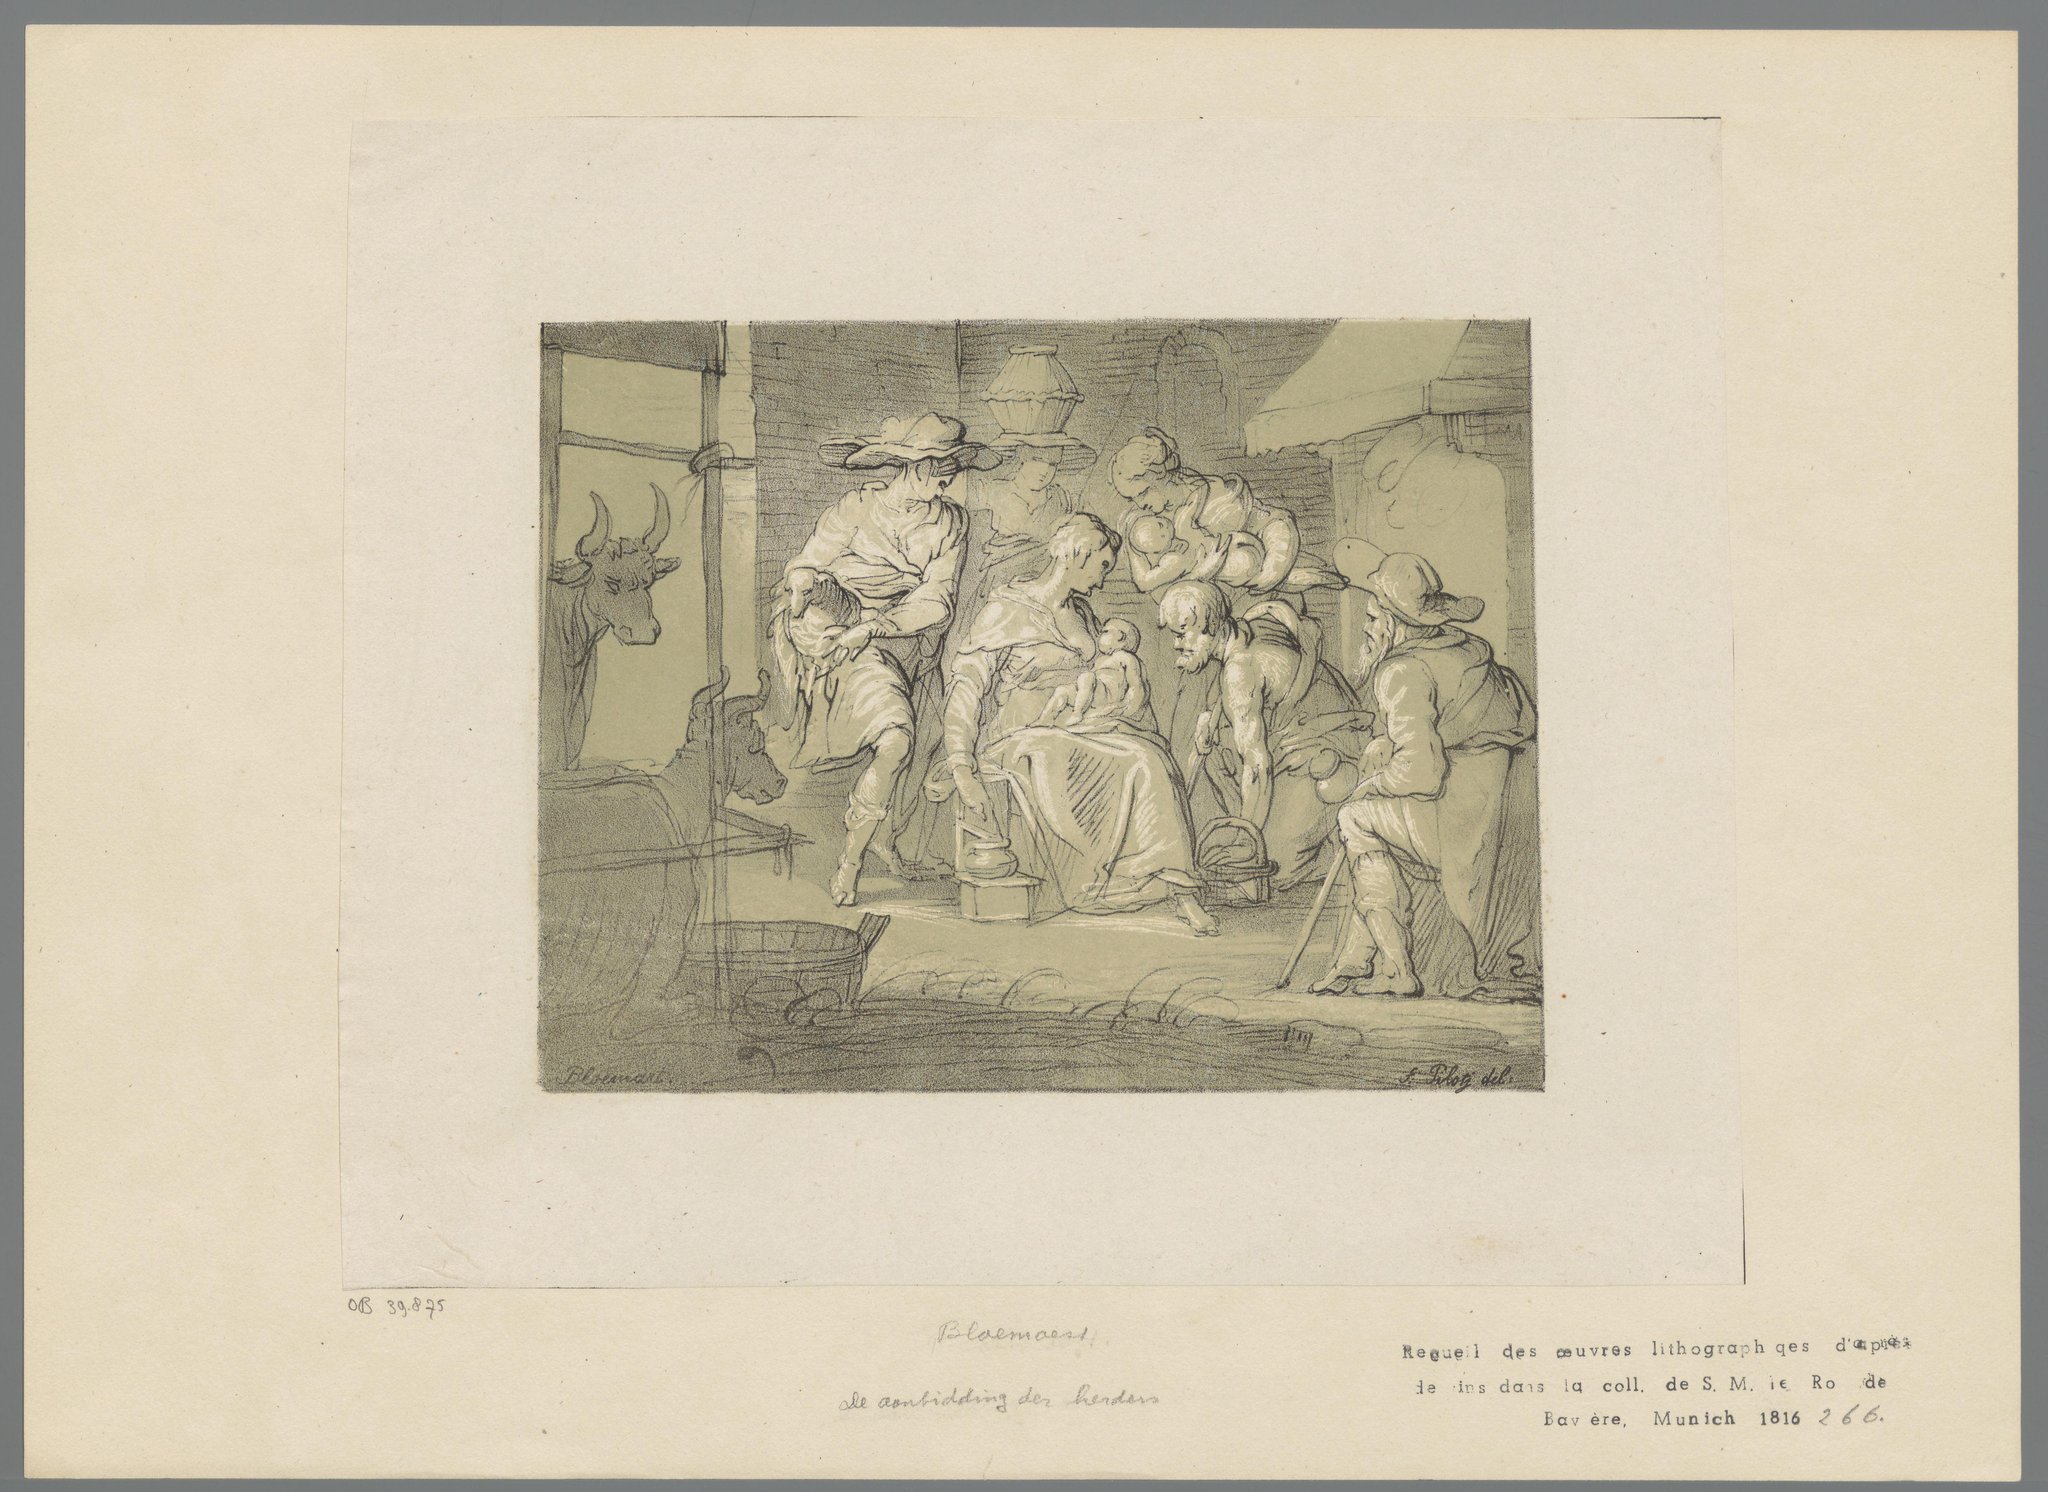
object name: print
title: Aanbidding door de herders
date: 1810-1816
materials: paper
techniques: tone lithography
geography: munich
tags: adoration of the christ-child by the shepherds; mary and joseph present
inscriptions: inscription: ‘Recueil des oeuvres lithograph qes d'arpes de [...] dans la coll. de S.M. ie Ro de Bavère, Munich 1816’, collector's mark: Lugt 2166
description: Prent behoort tot de serie 'Les Oeuvres Lithographiques, choix de dessins d'après les grands maitres de toutes les Ecoles, tirées du Musée de S.M. le roi de Bavière par Strixner, Piloty et Cie'. Deze serie werd door J. Stunz in München in 72 delen van elk zes bladen gepubliceerd tussen 1810 en 1816; in totaal 432 prenten. Mogelijk is dit prent 266.